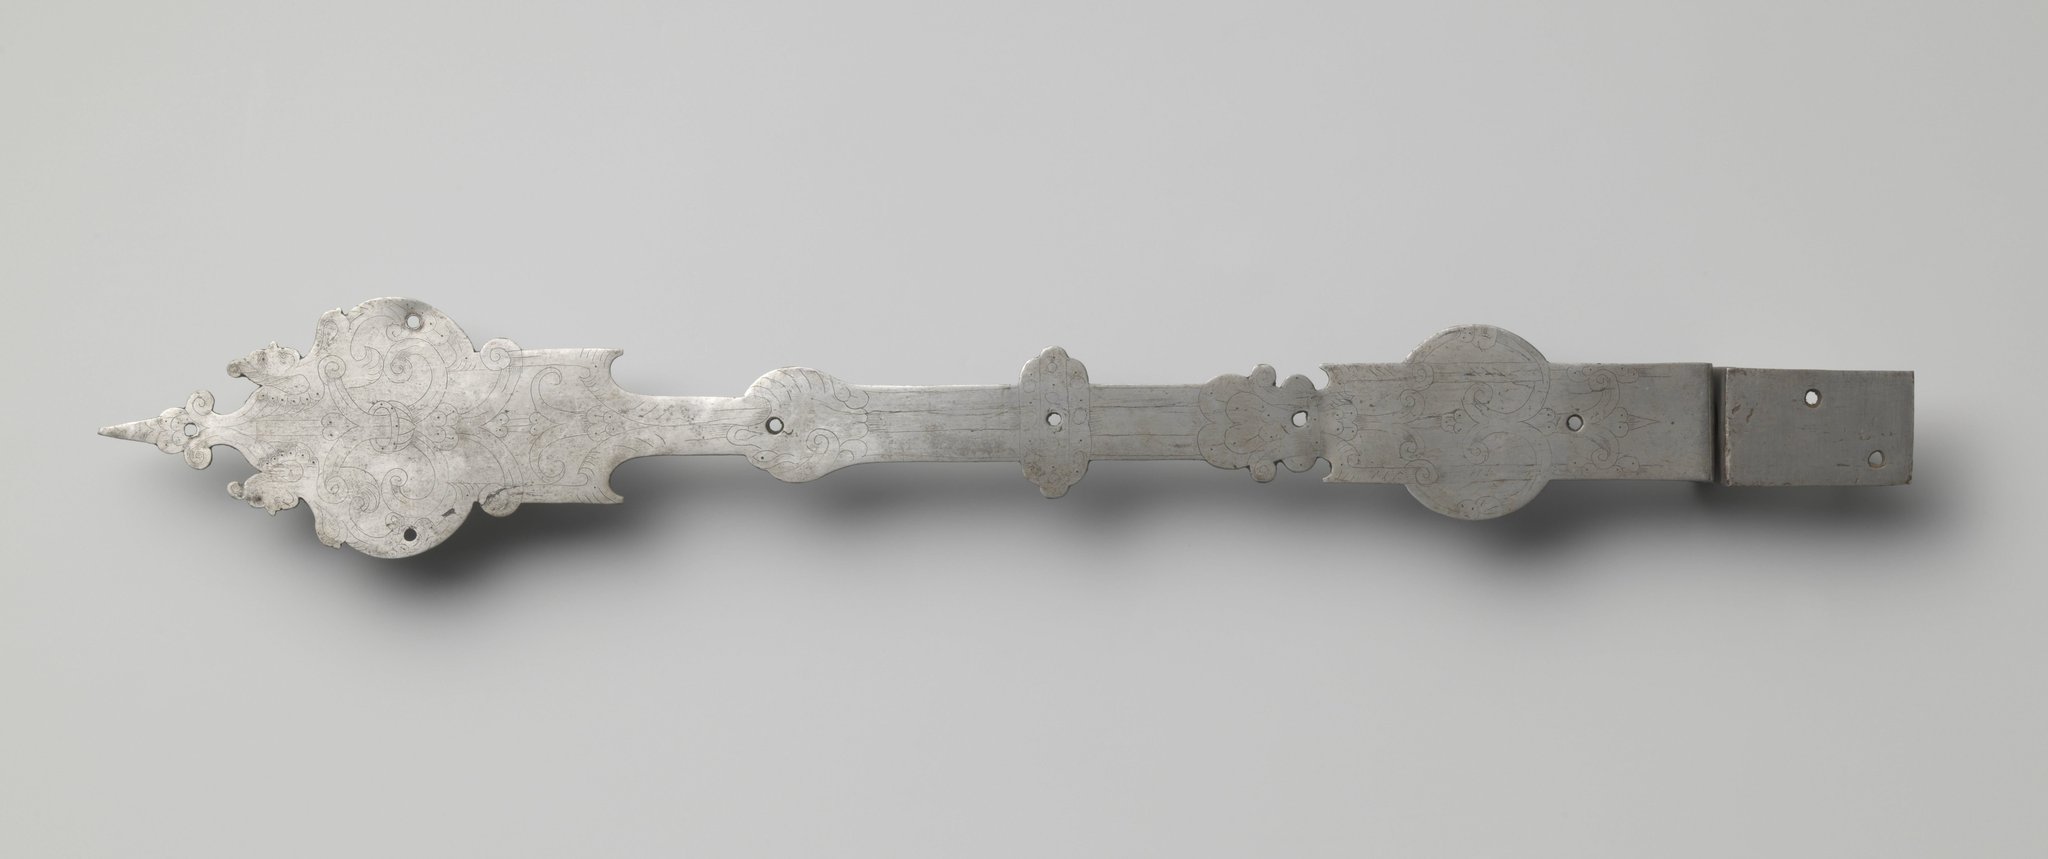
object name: hengsel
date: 1400-1950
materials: iron